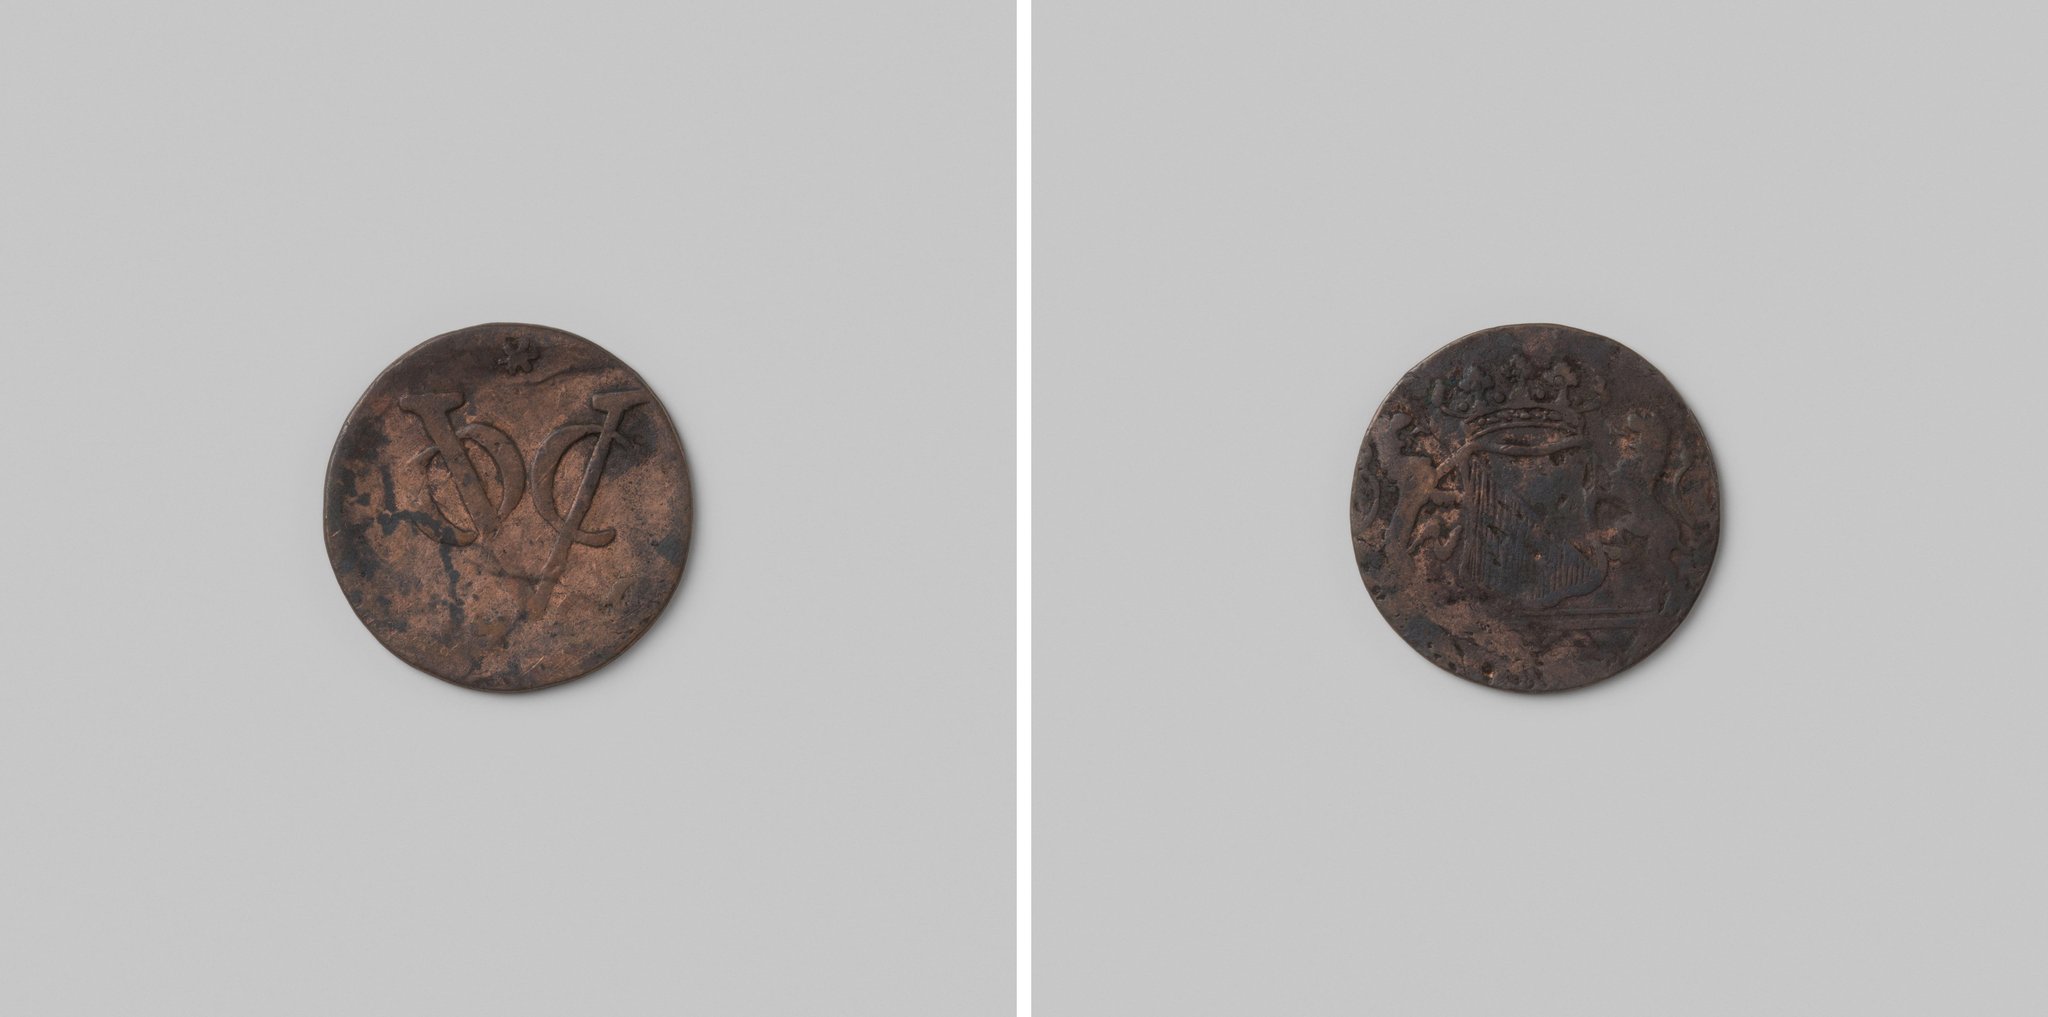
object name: coin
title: Koperen muntje uit Oost-Indië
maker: Anonymous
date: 1700-1900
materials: copper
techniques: striking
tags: verenigde oostindische compagnie, oost-indië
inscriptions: inscription: ‘VOC (als teken van de VOC, letters door elkaar, geschreven)’, inscription: ‘Jacques Schulman N.V. / Numismaten / Keizersgracht 448 / Amsterdam-C.’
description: Koperen muntje. Voorzijde: het teken van de VOC (VOC door elkaar heen geschreven). Keerzijde: door twee leeuwen vastgehouden wapen. Het muntje zit in een vierkant envelopje met opschrift.